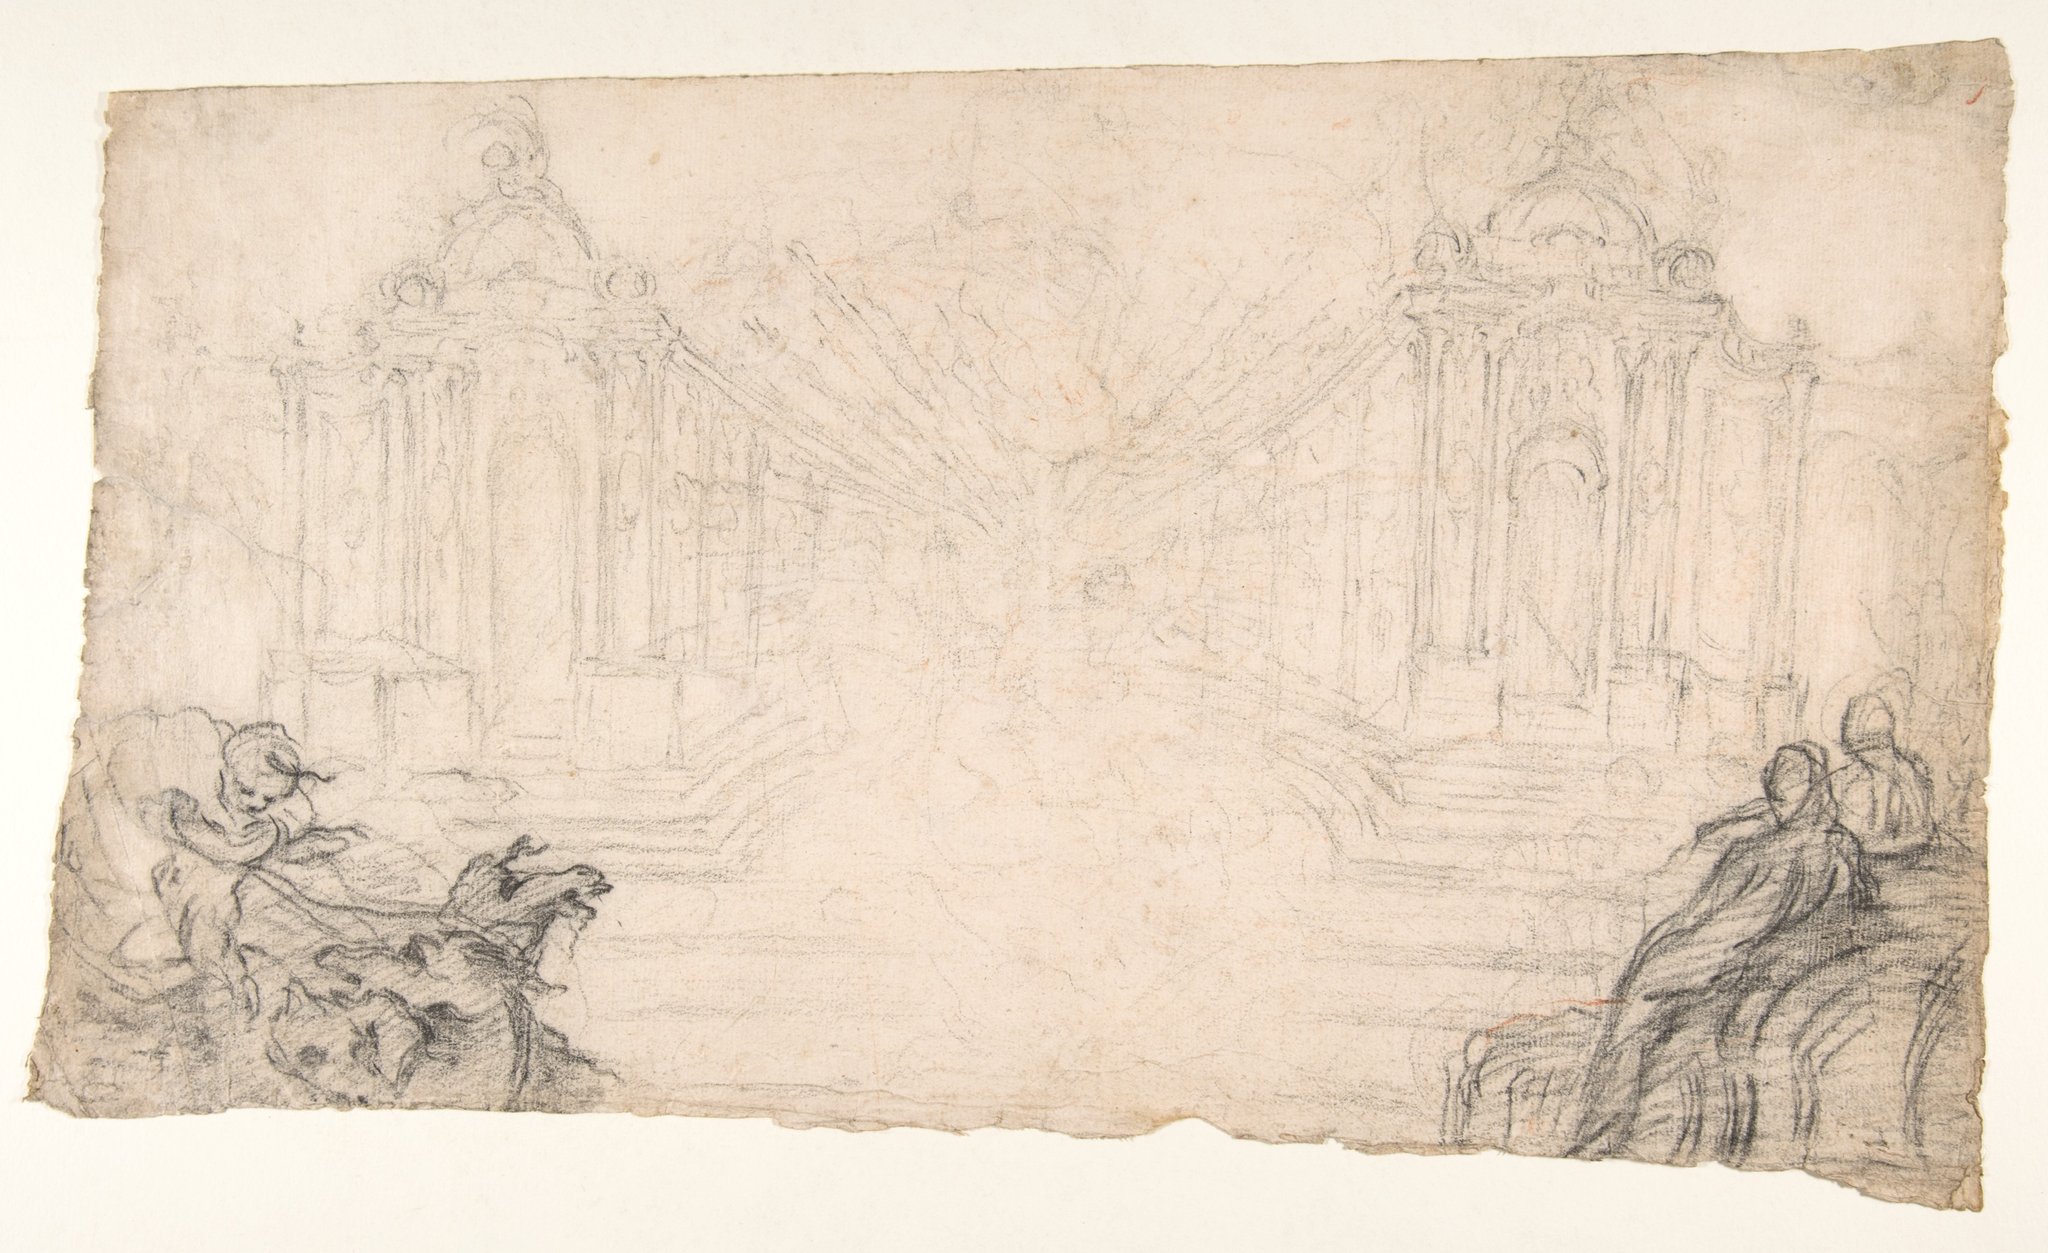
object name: drawing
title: Design for a Festival Display of Fireworks (recto); Small Figures by a different hand (verso)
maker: laurent hubert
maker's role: artist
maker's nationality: french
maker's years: 1780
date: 1701-1800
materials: chalk, graphite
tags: human figures,buildings,fireworks